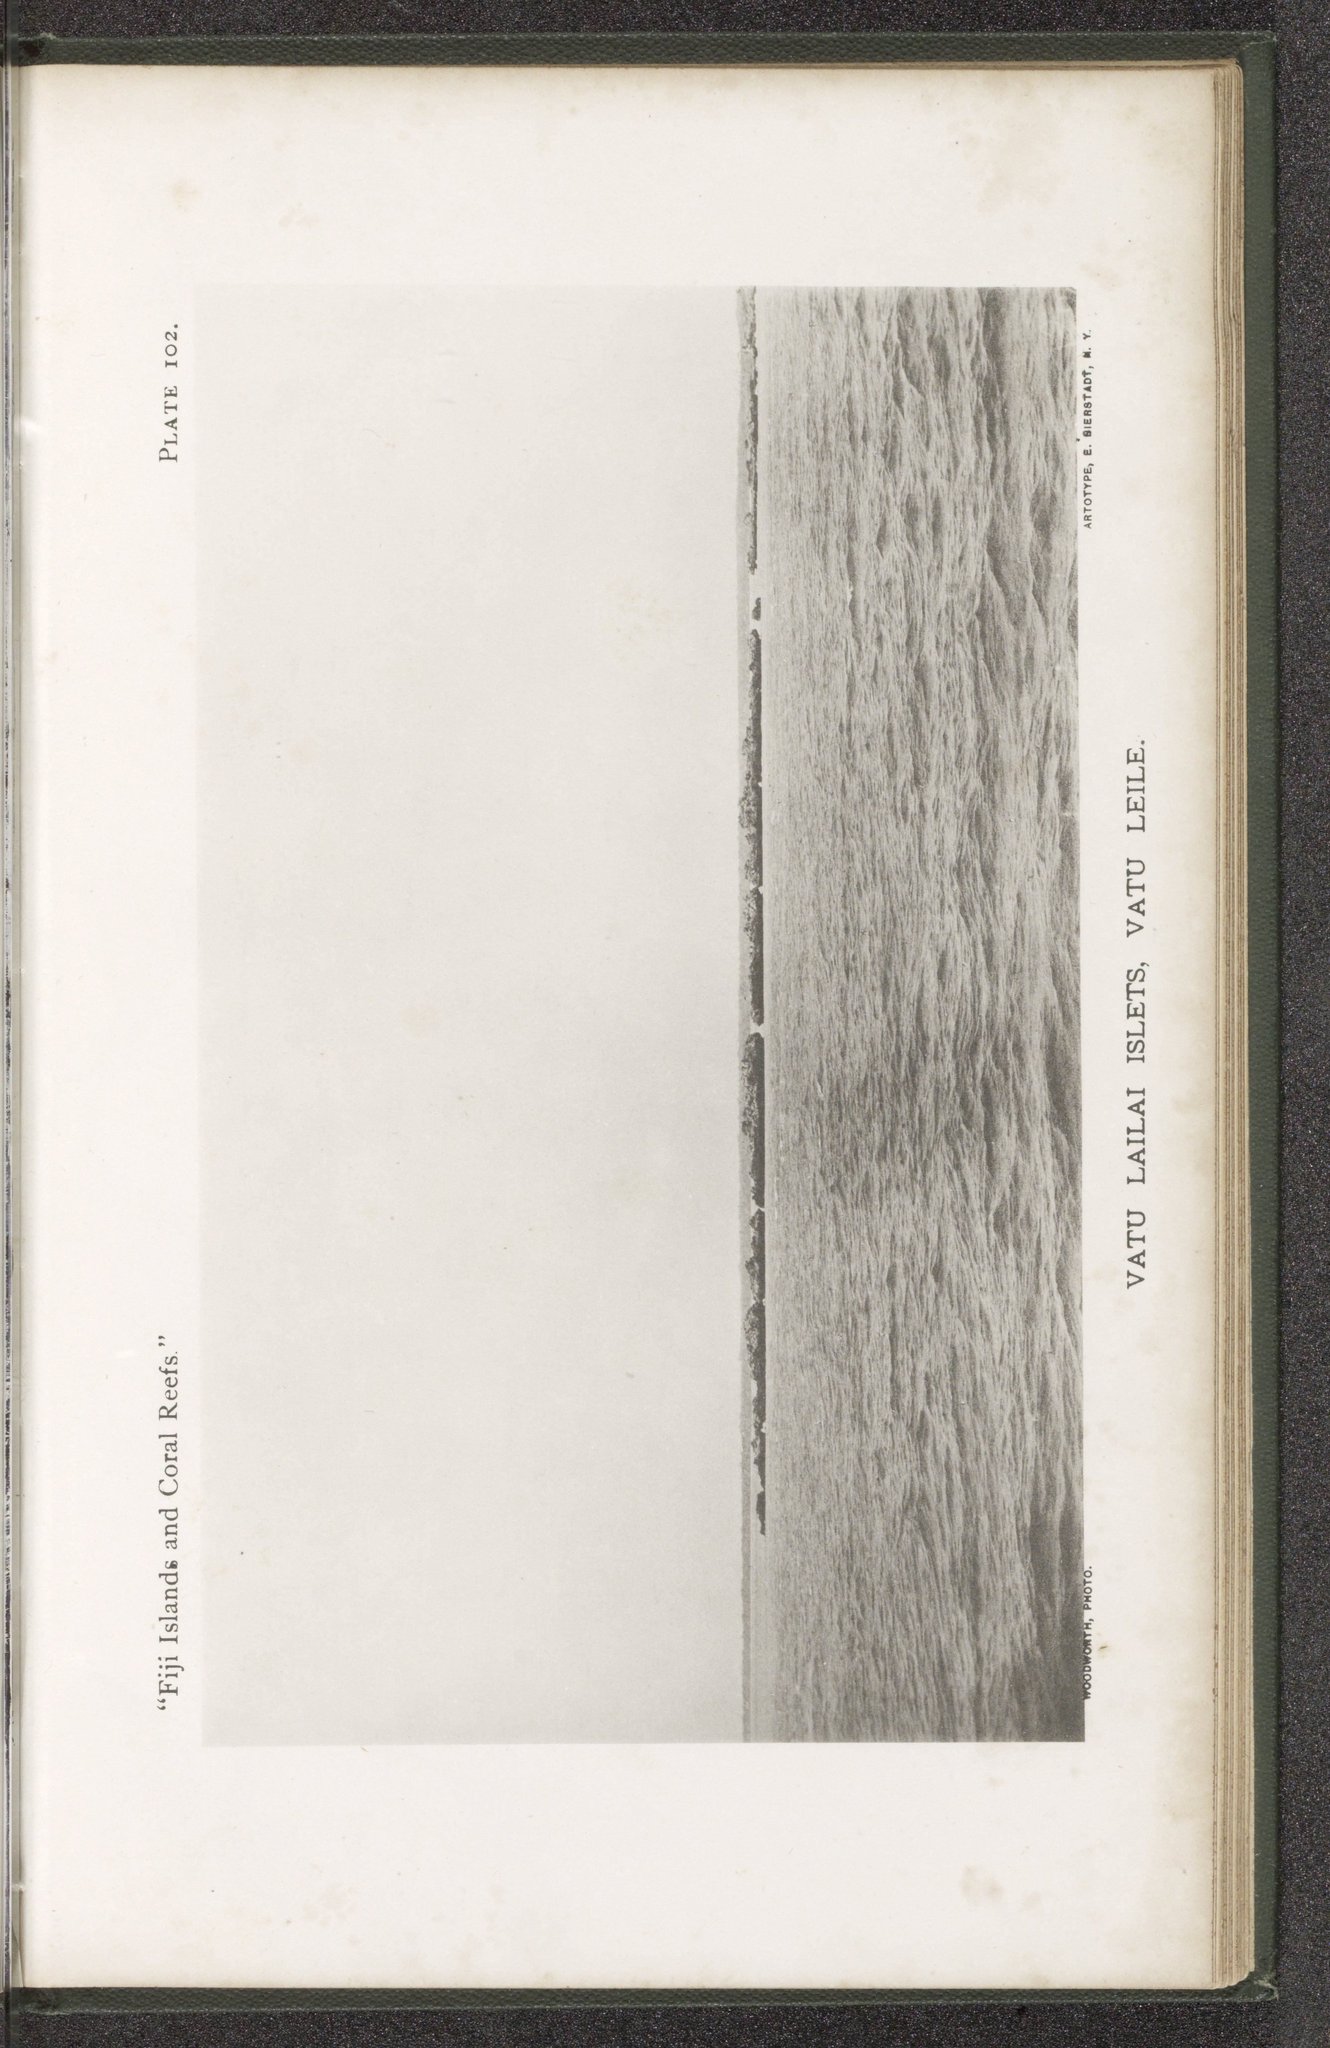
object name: photomechanical print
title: Vatu Lailai islets, Vatu Leile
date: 1885-1899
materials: paper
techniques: photograph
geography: fiji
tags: island, haff, lagoon created by sand, shingle bank ~ coast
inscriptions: name: ‘Artotype, E. Bierstadt N. Y.’, name: ‘Woodworth, Photo.’, number: ‘Plate 102.’